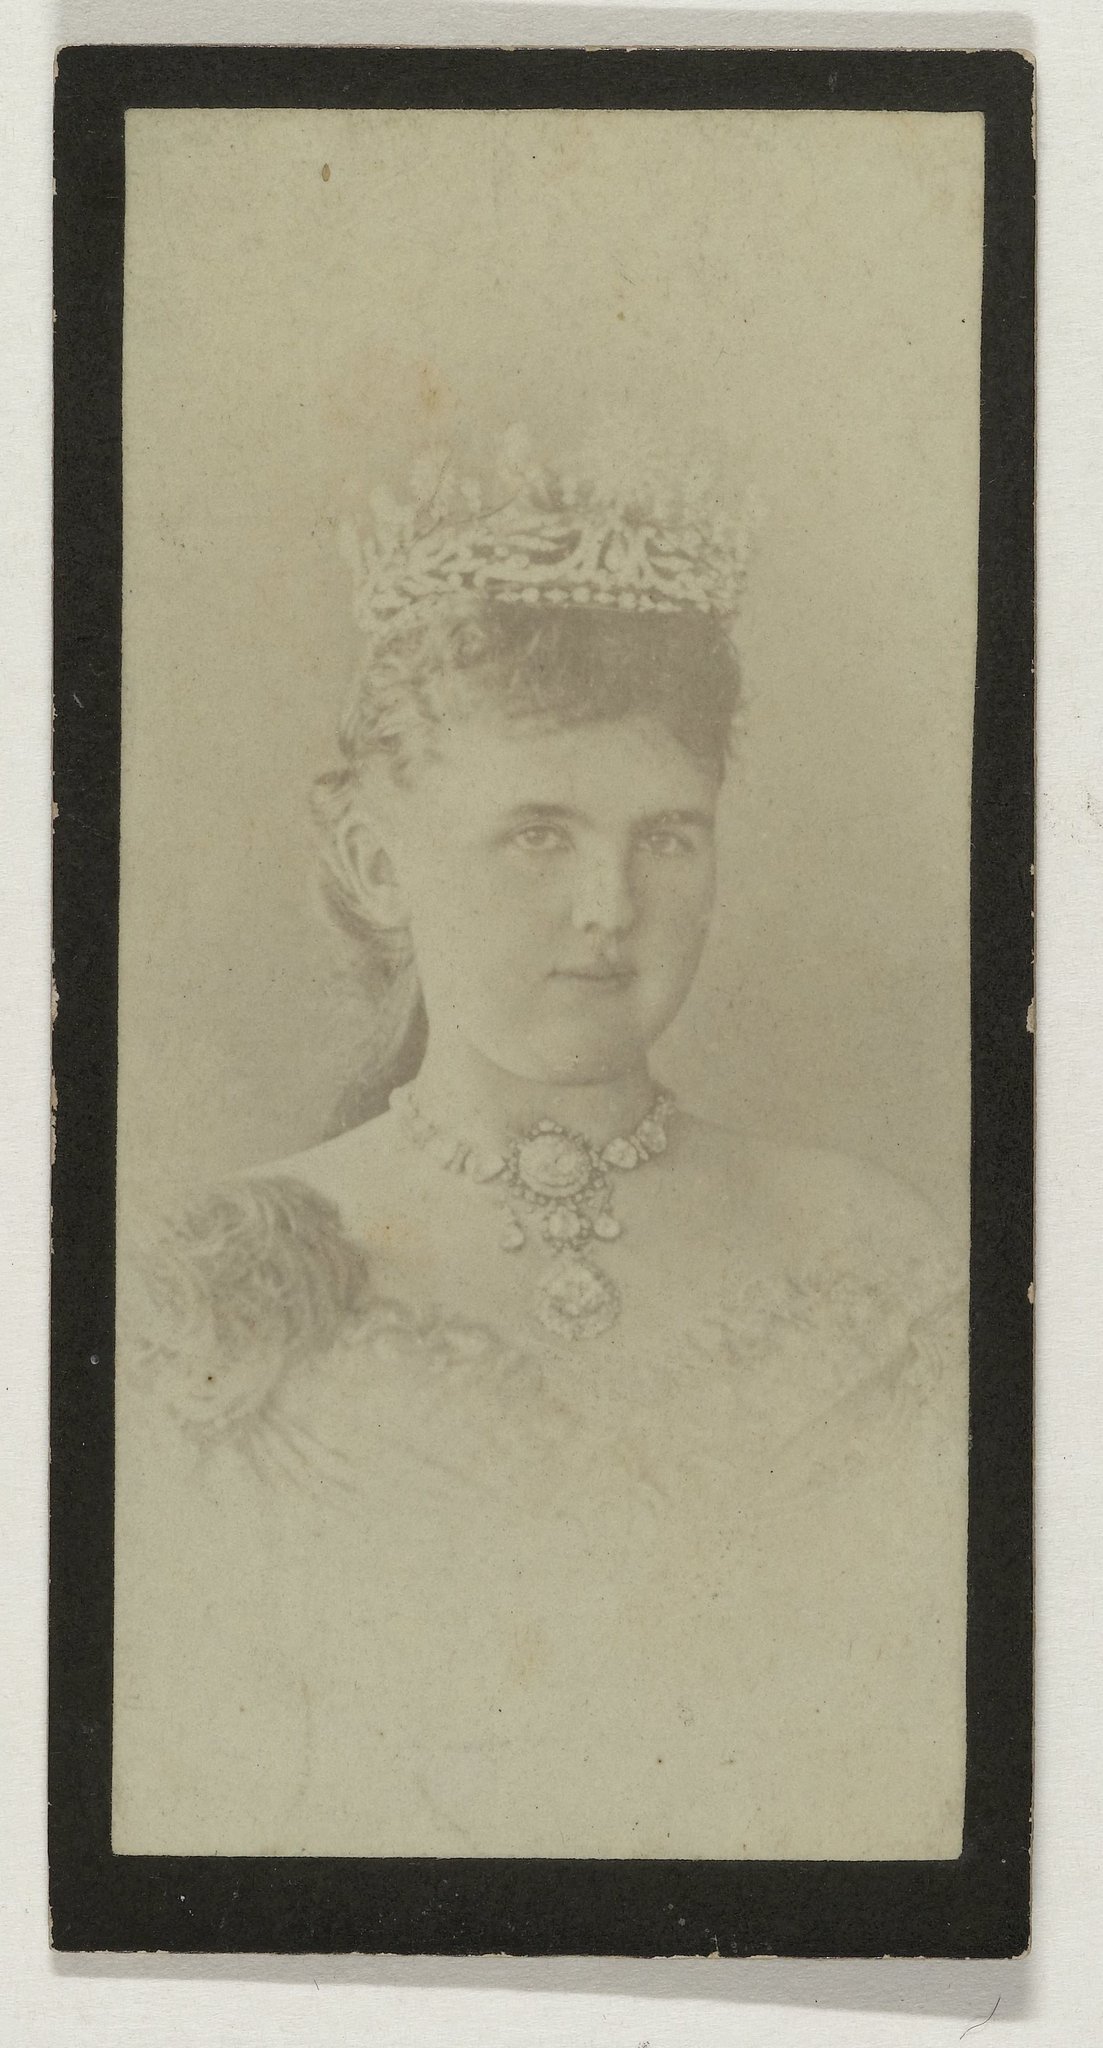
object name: photograph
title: Portret van koningin Emma op jonge leeftijd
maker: Anonymous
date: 1898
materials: cardboard, paper, photographic support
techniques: albumen print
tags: emma (queen consort of the netherlands)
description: Portret van koningin Emma op jonge leeftijd.